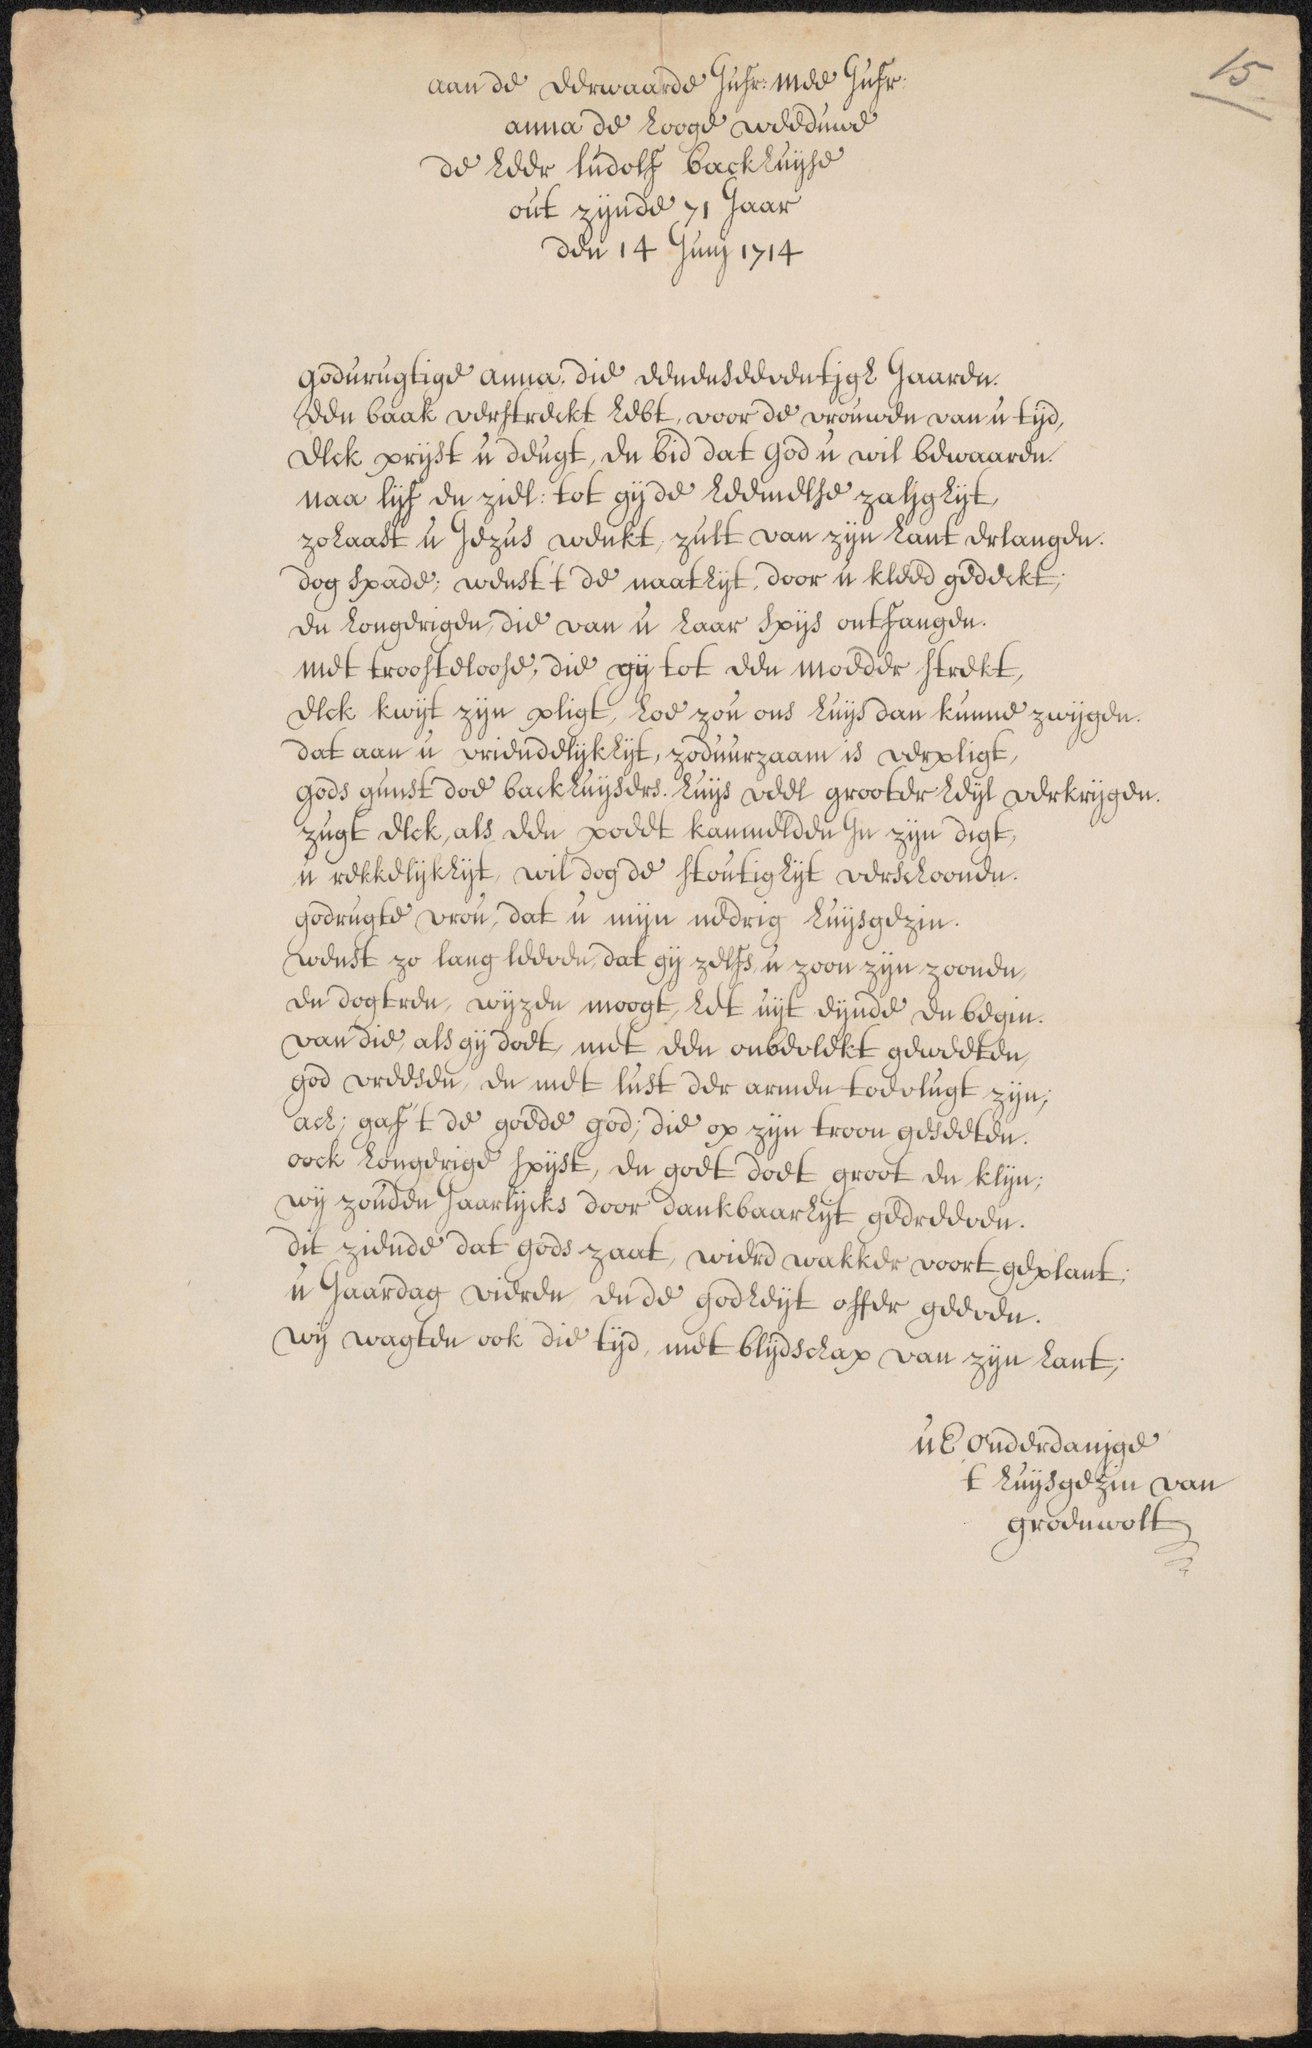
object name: poem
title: Gedicht aan Anna de Hooghe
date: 1714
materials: ink, paper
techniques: pen, writing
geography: amsterdam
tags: anna de hooghe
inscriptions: collector's mark: Lugt 2233, watermark